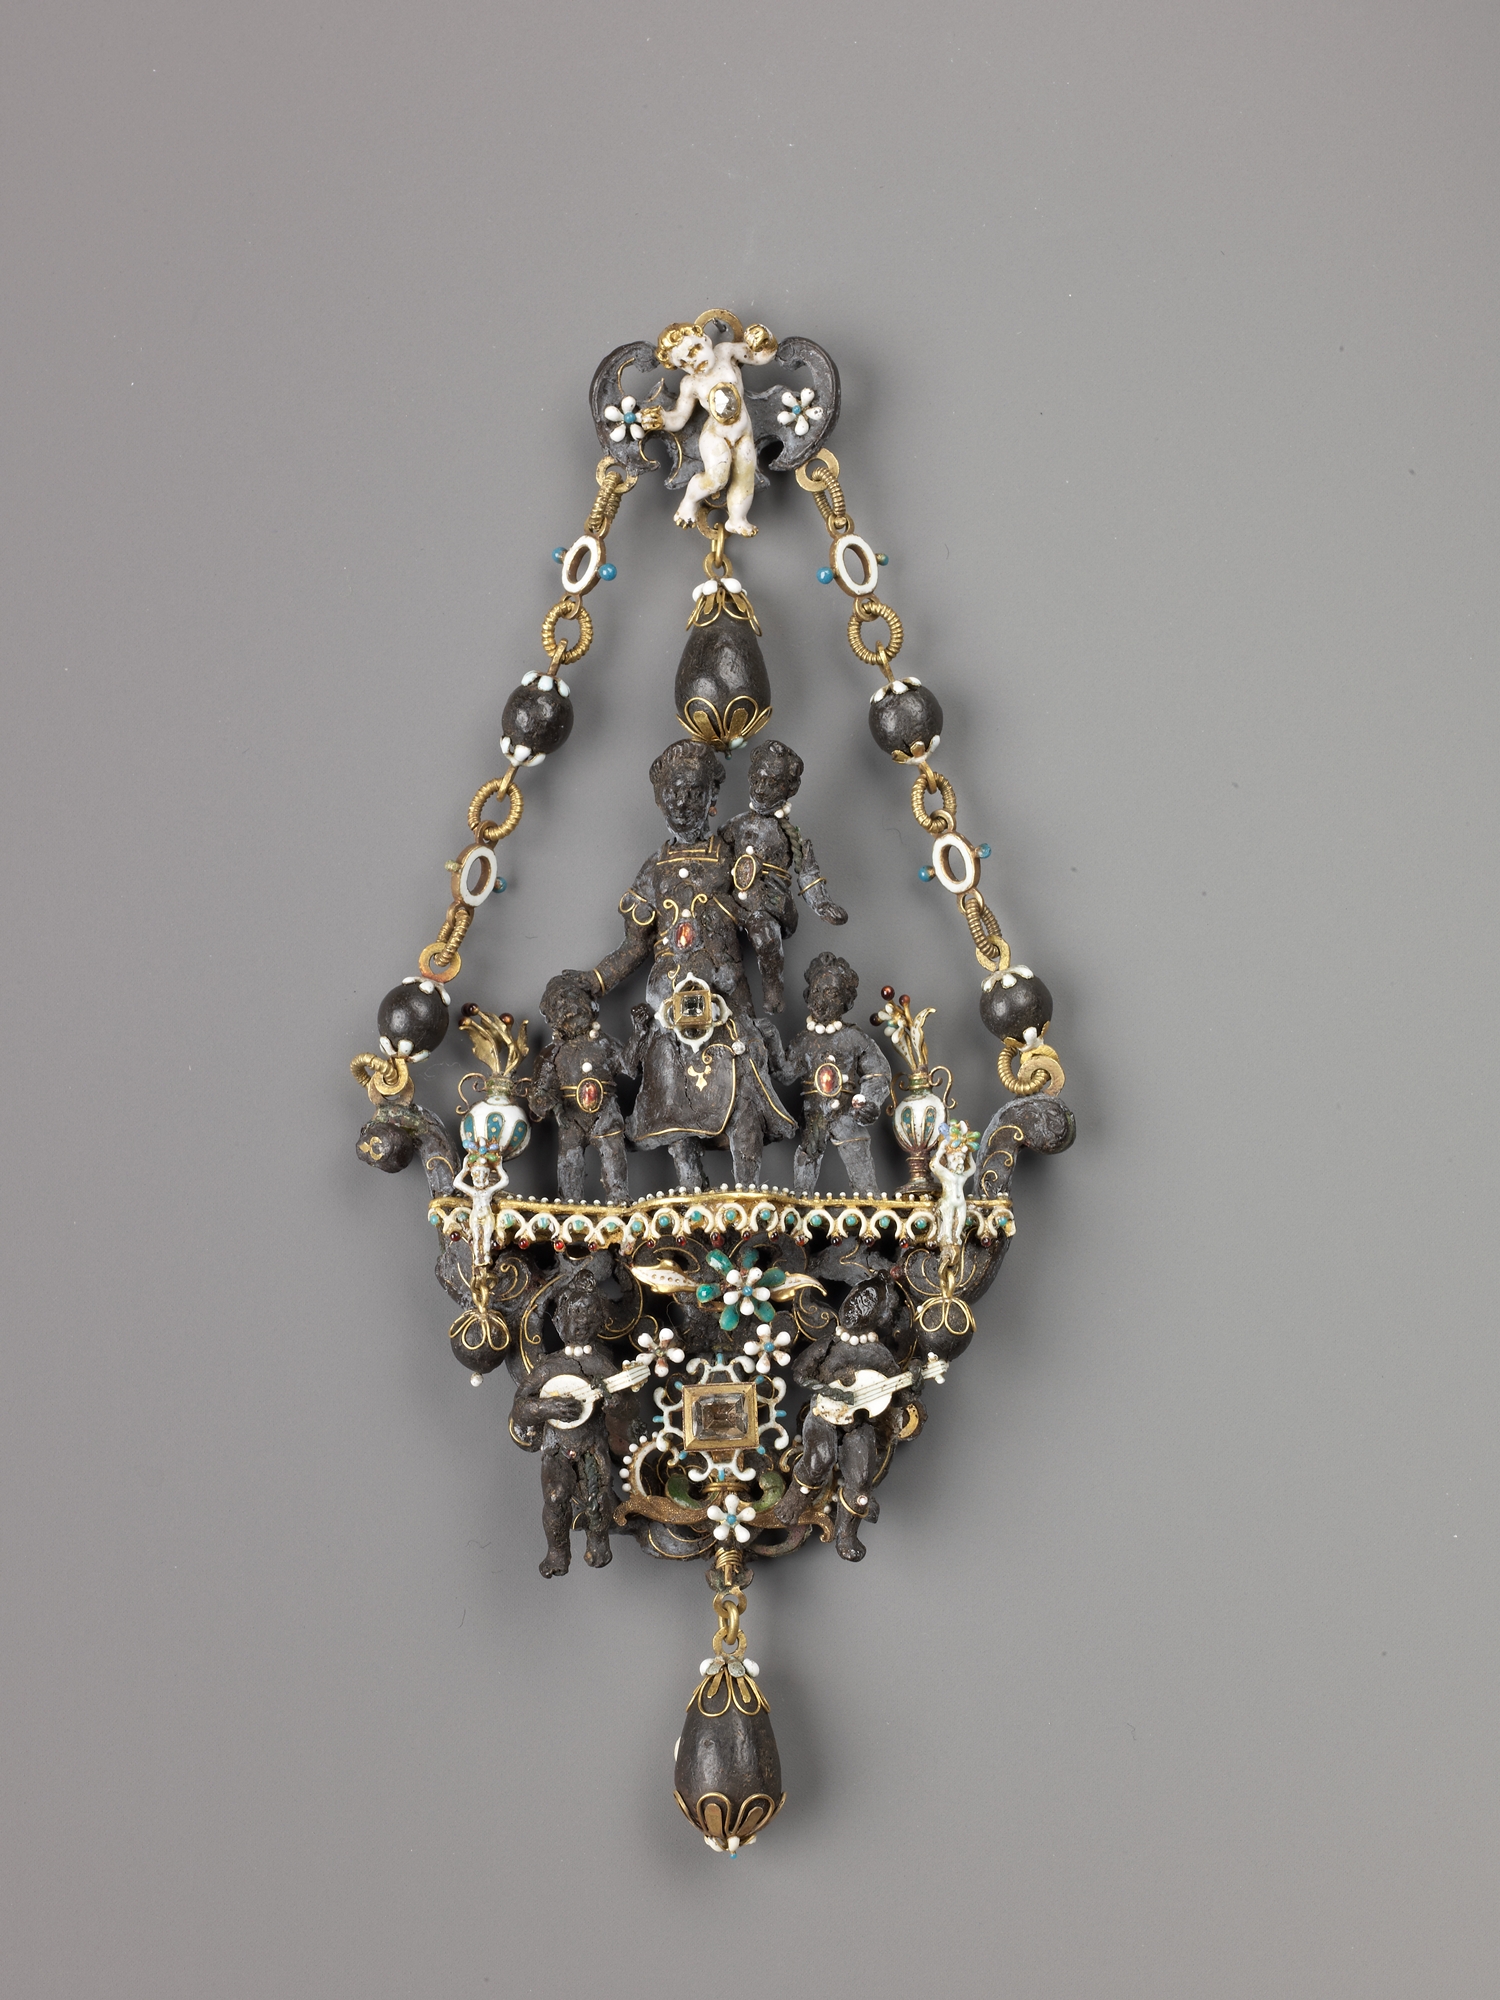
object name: pendant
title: Pendant of "Ambergris"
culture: european, western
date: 1867-1900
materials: diamond, enamel, gold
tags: children,women